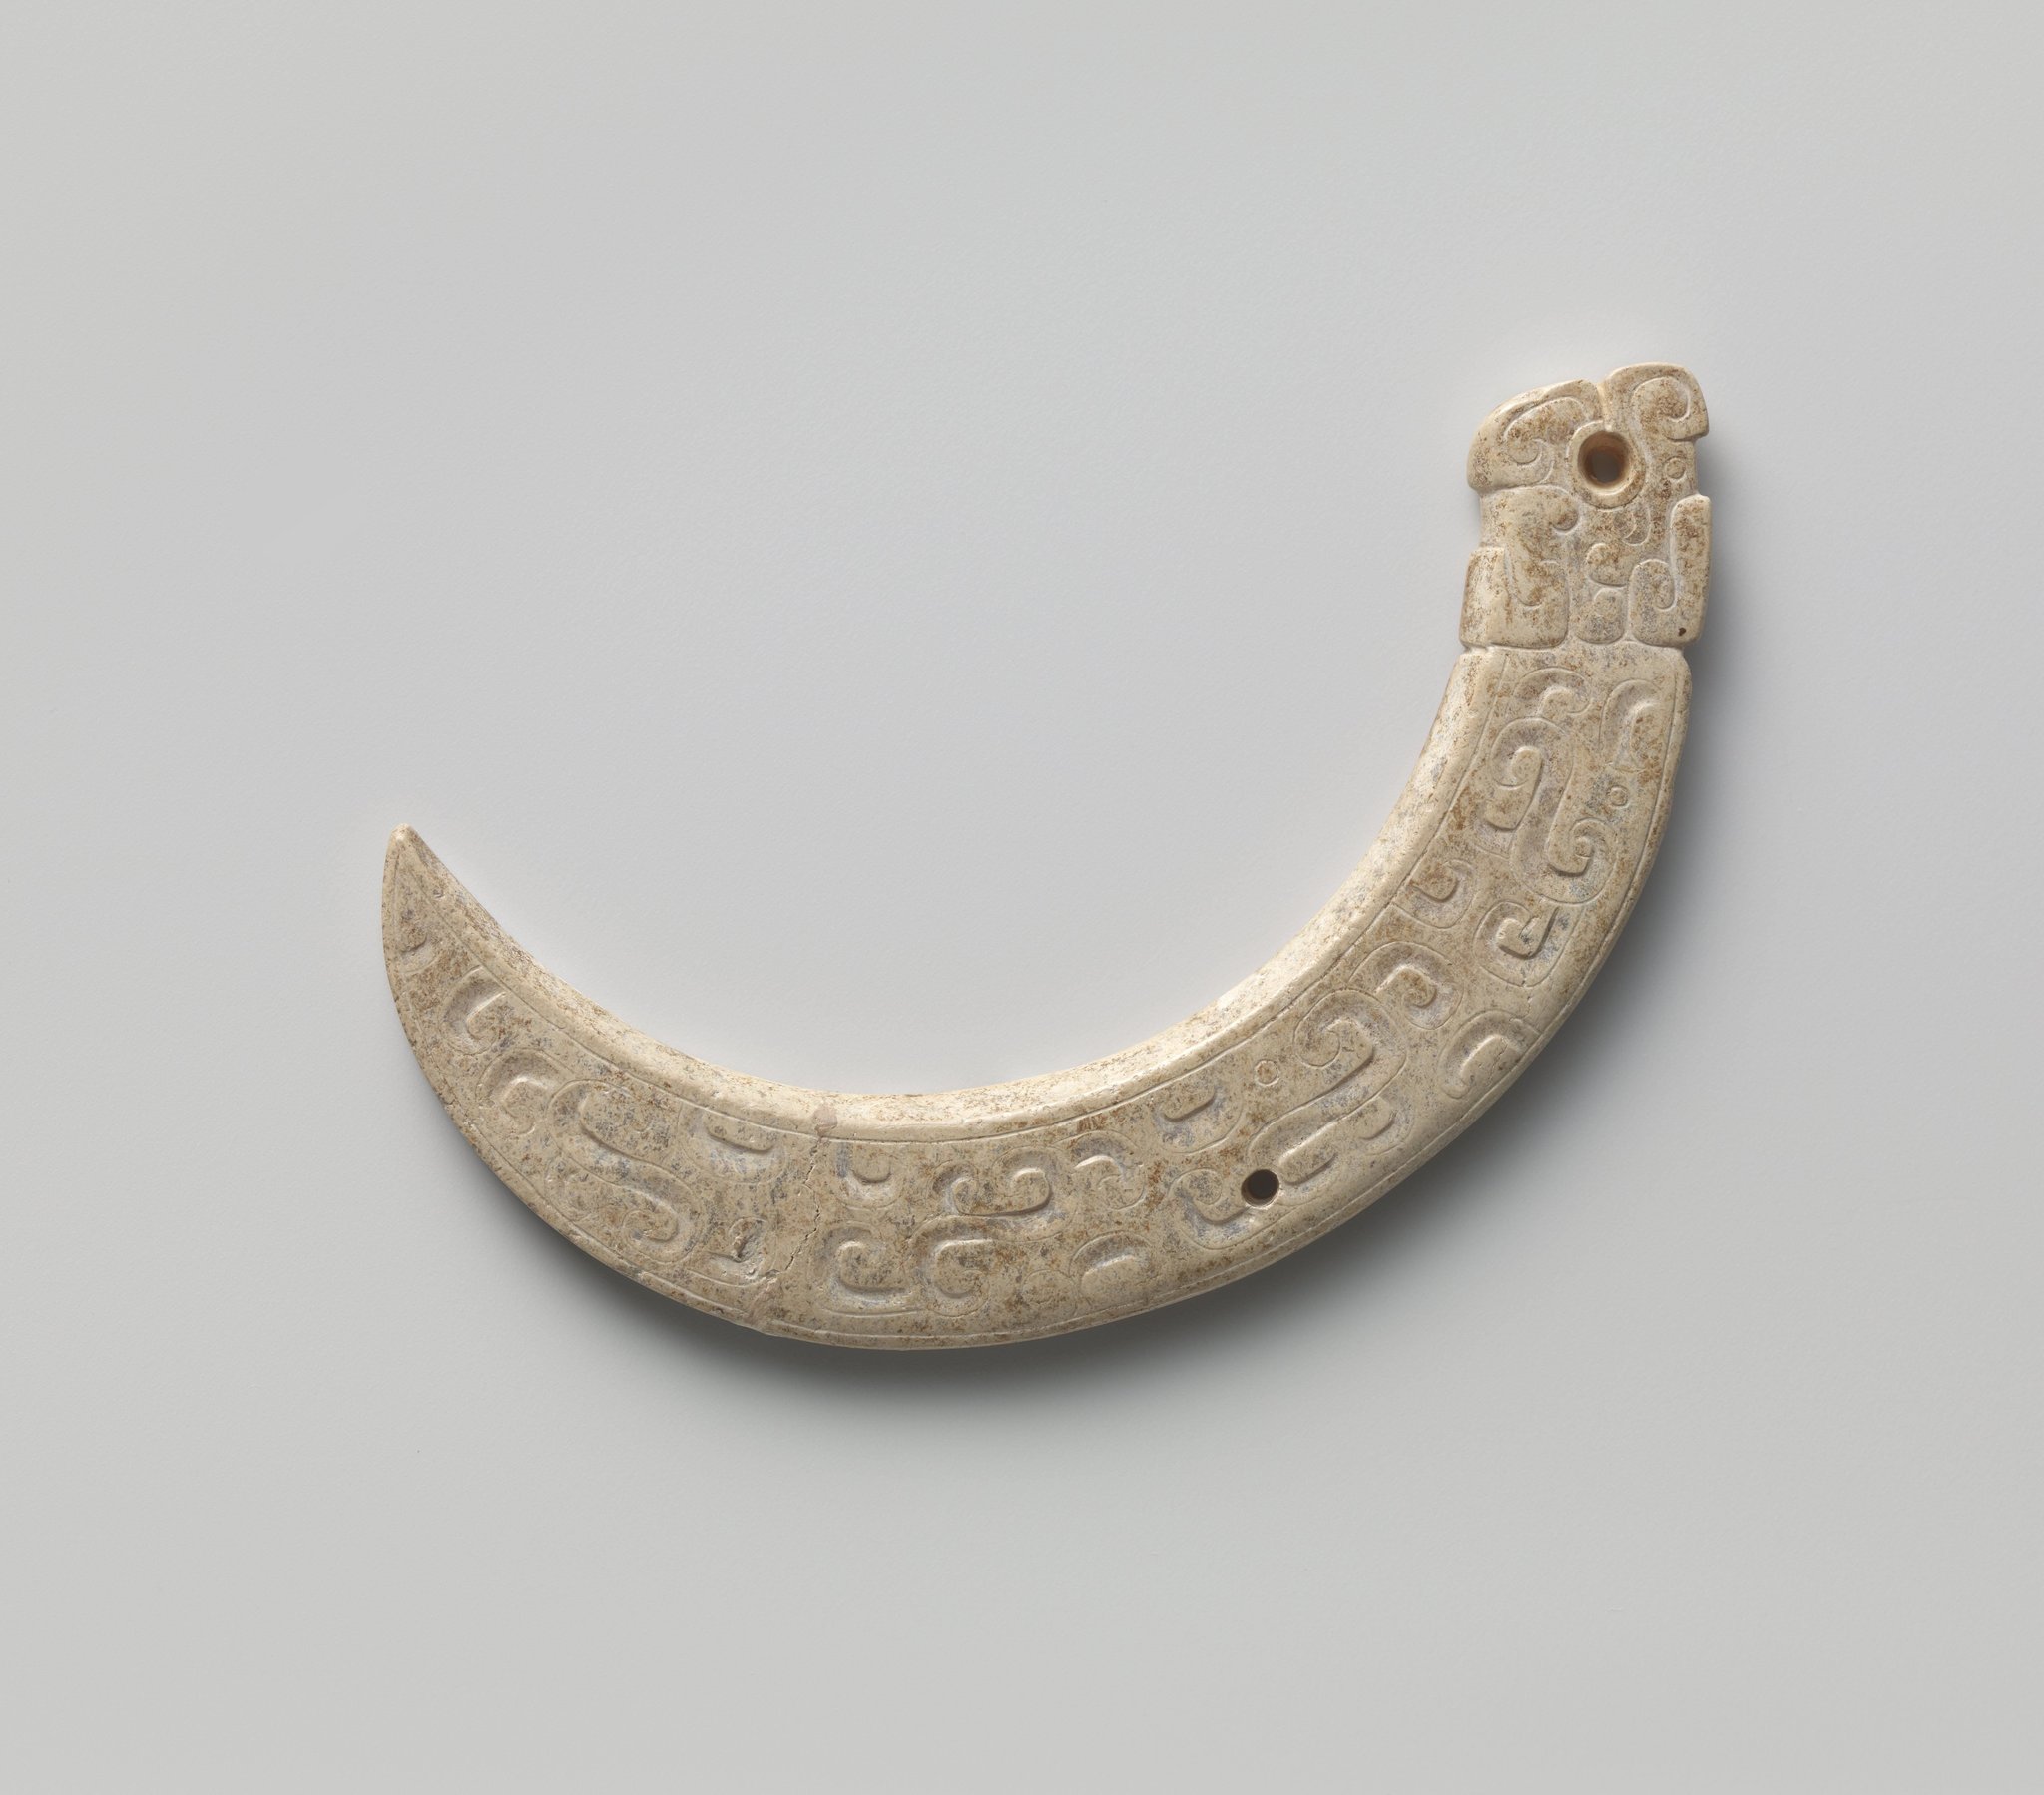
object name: sculpture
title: Decoratief object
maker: Anonymous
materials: jade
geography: china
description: Circular ornament with feather motif decoration. China. Late Eastern Zhou period (481 - 222 BC). Jade. (Given by C.T. Loo)